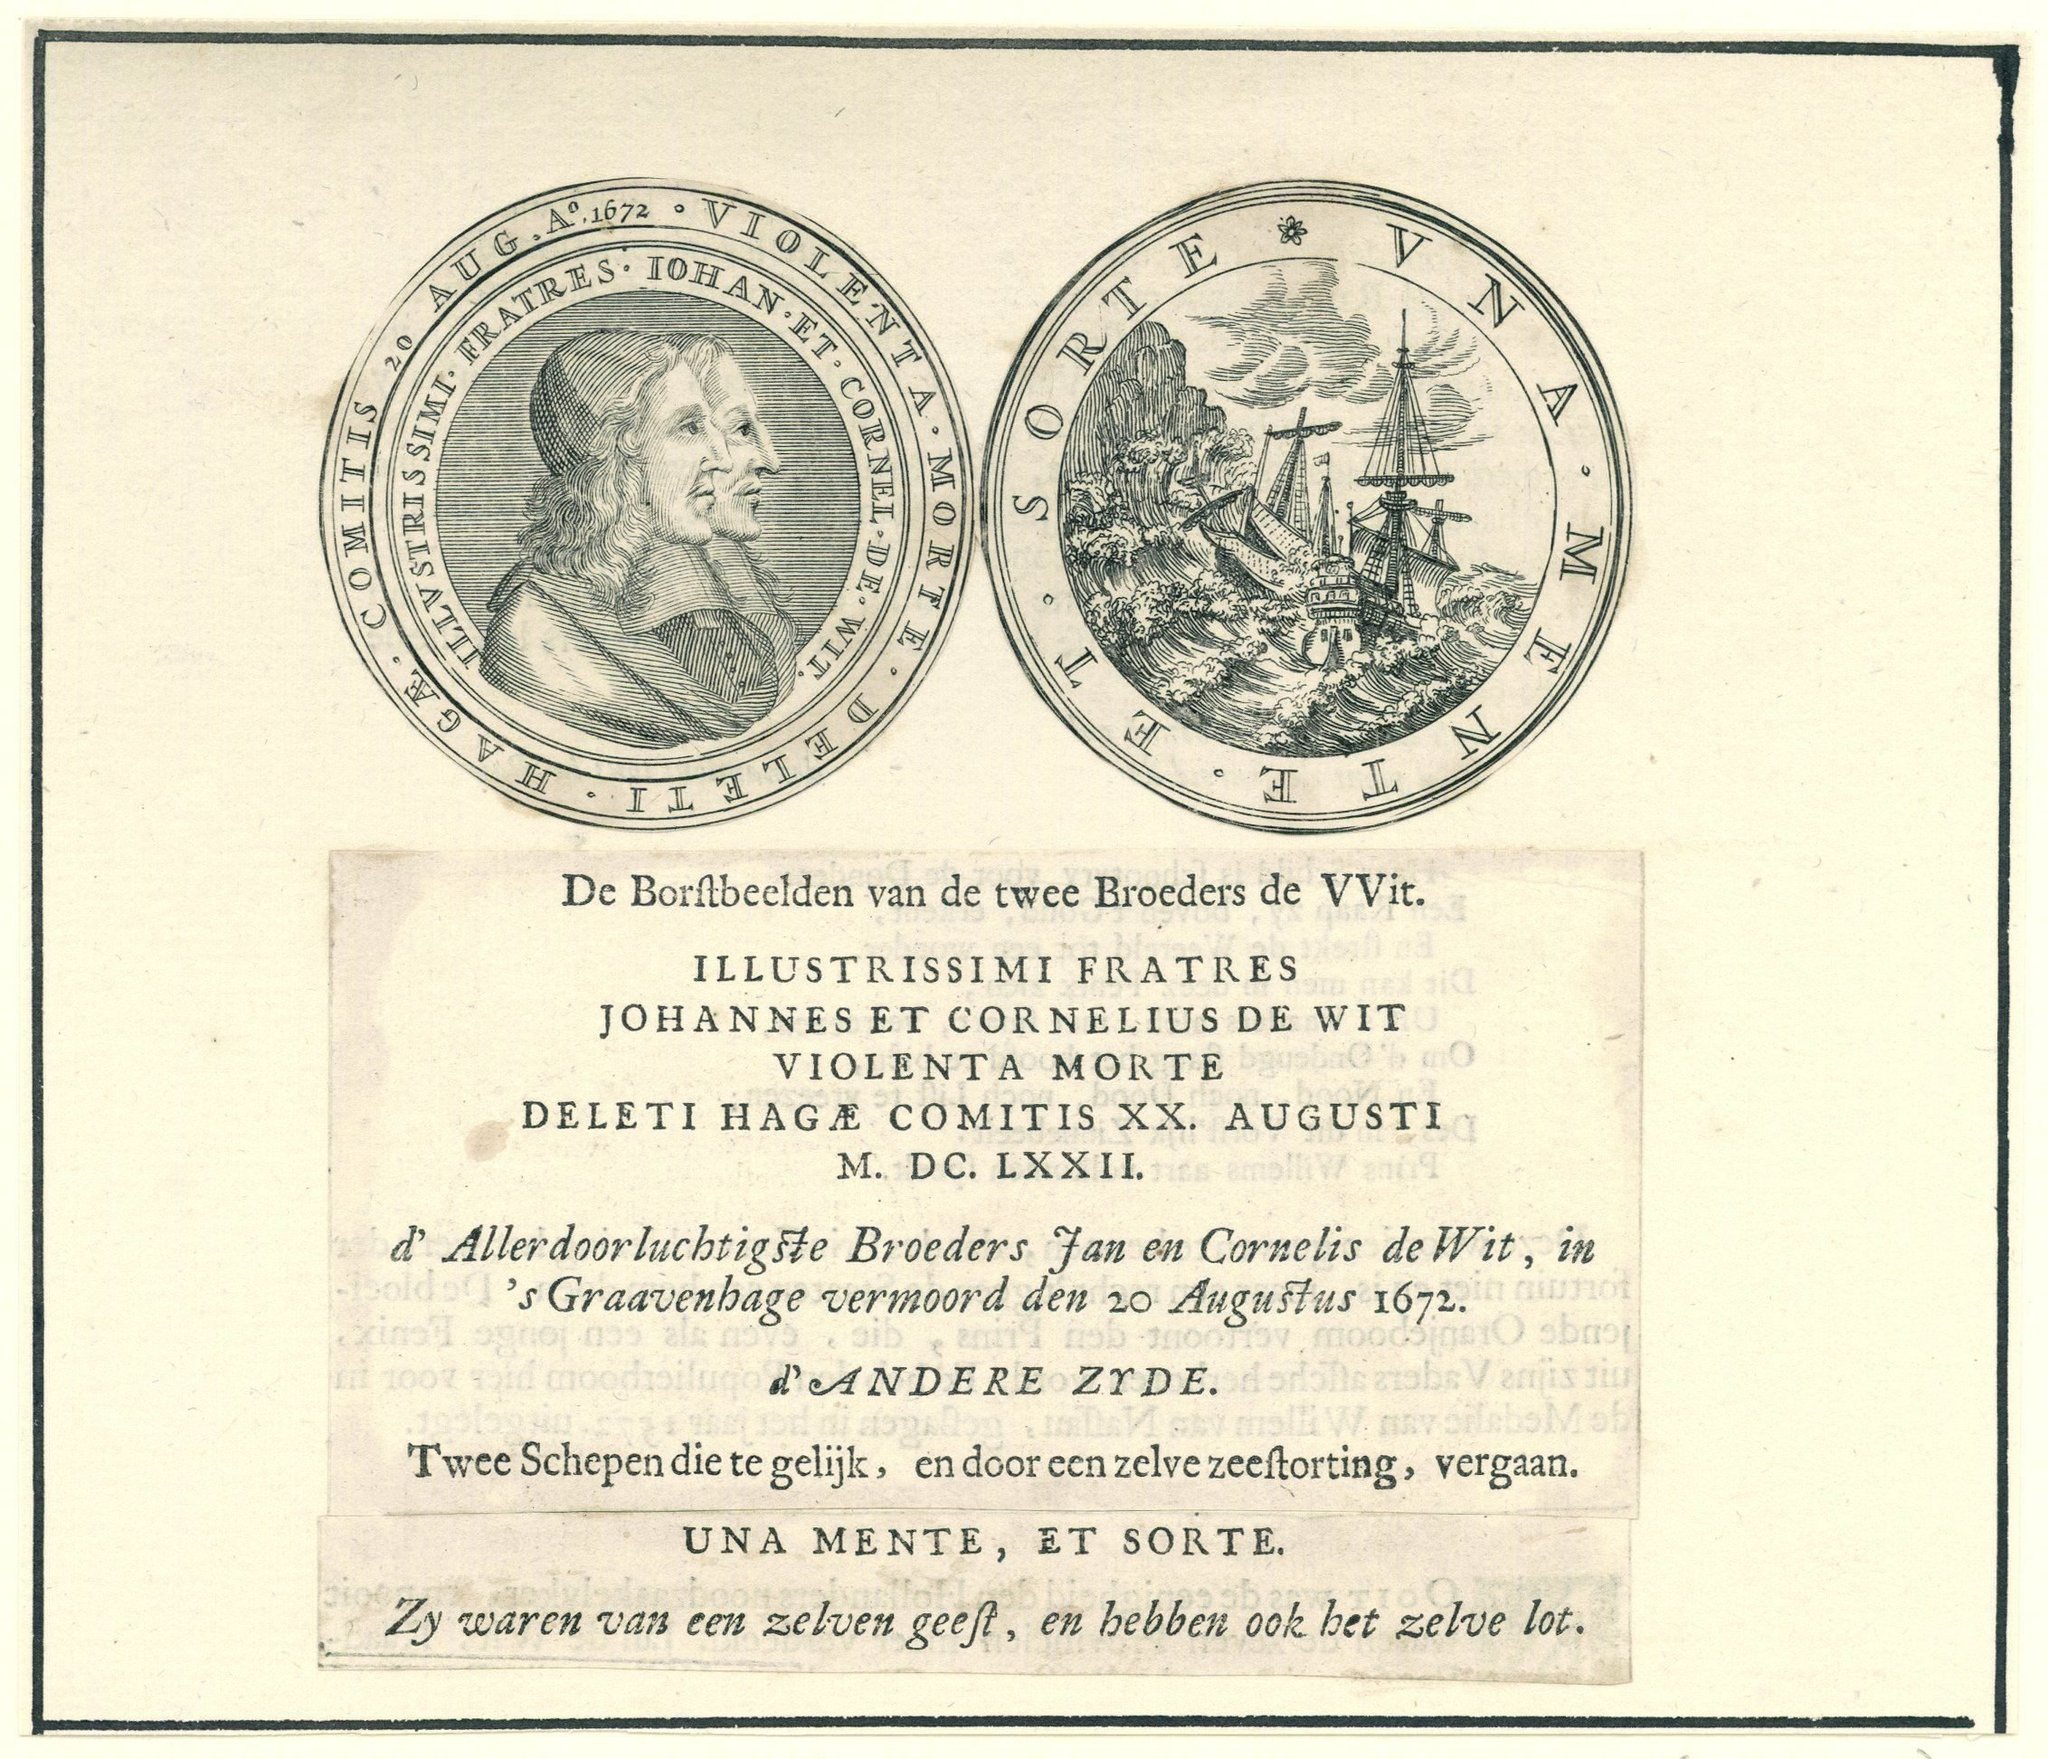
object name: penningverklaring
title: Penning ter ere van de gebroeders De Witt, 1672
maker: Anonymous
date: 1672-1749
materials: paper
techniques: engraving, etching, letterpress printing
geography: northern netherlands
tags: dordrecht, cornelis de witt, the hague, politician, johan de witt, medal (considered as a piece of sculpture, regardless of its specific function)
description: Blad met de voor- en achterzijde van een penning vervaardigd ter nagedachtenis aan Johan en Cornelis de Witt, gedood in 1672. De voorzijde toont de portretten van de gebroeders en profil. Op de keerzijde twee schepen die in een storm vergaan. Op hetzelfde blad is een uitgeknipte beschrijving van de penning geplakt.